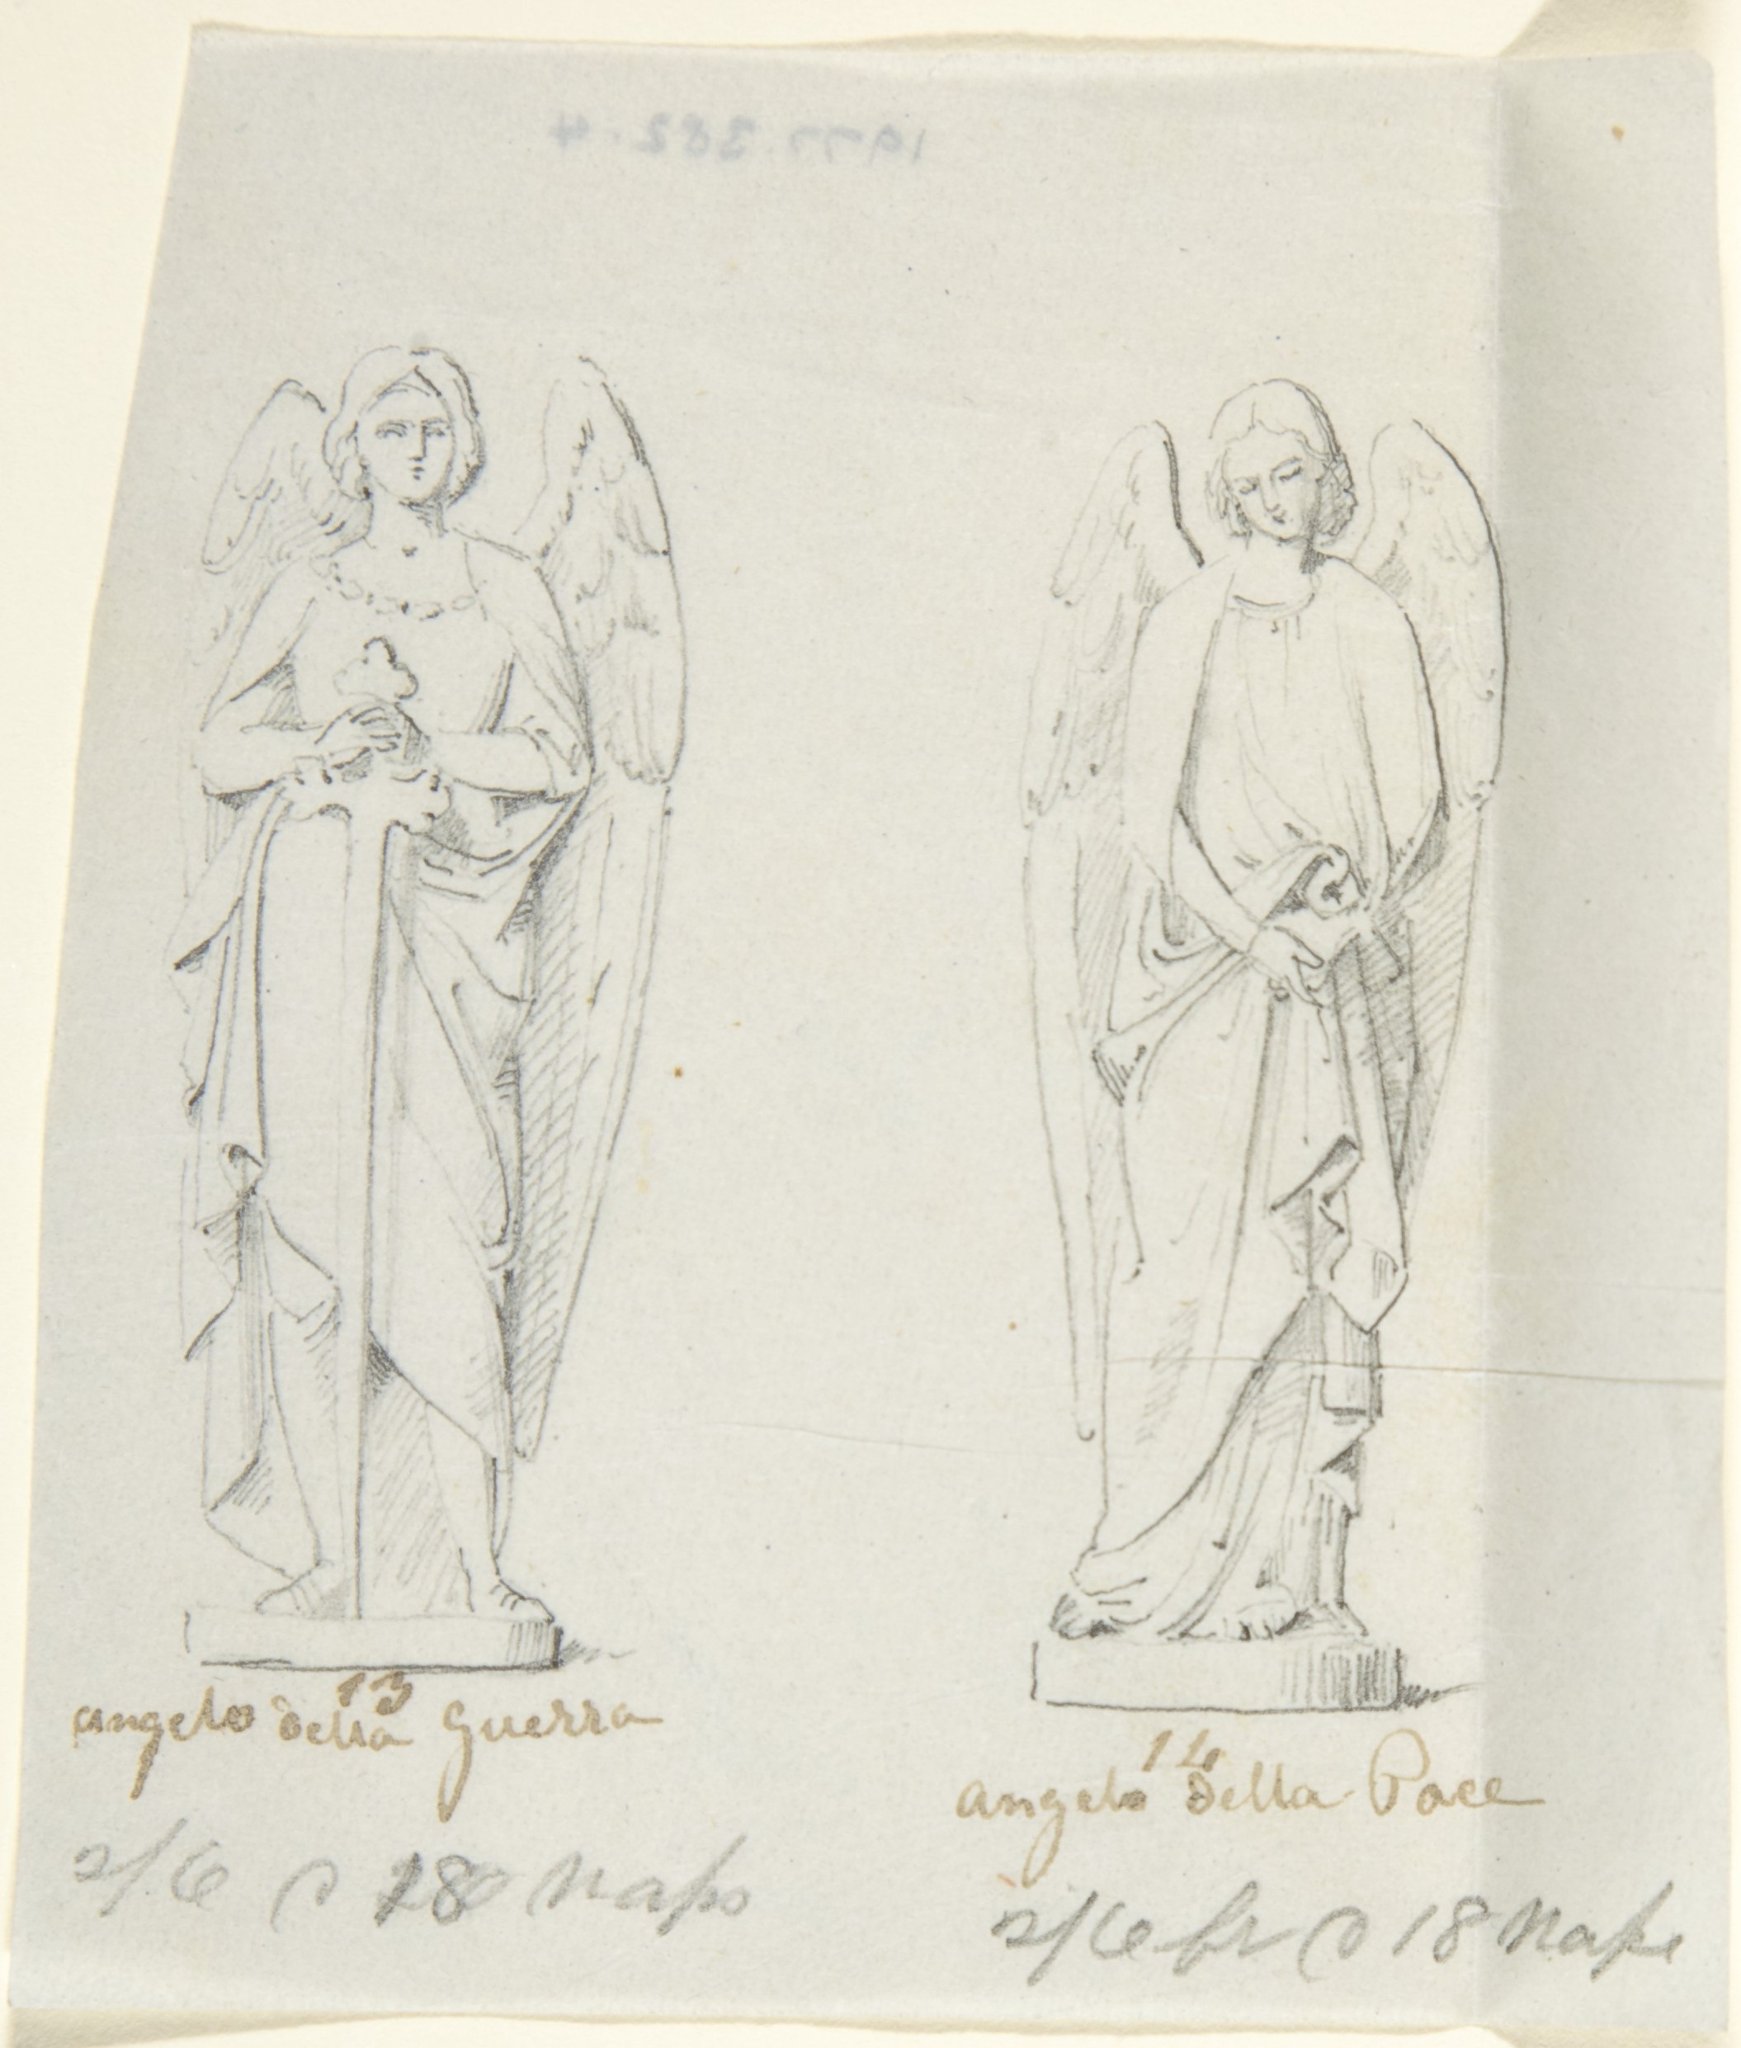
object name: drawing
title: Sketches of two statues: Angel of War and Angel of Peace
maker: john gibson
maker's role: artist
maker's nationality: british, born wales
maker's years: 1790-1866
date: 1850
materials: graphite, ink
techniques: pen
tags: angels